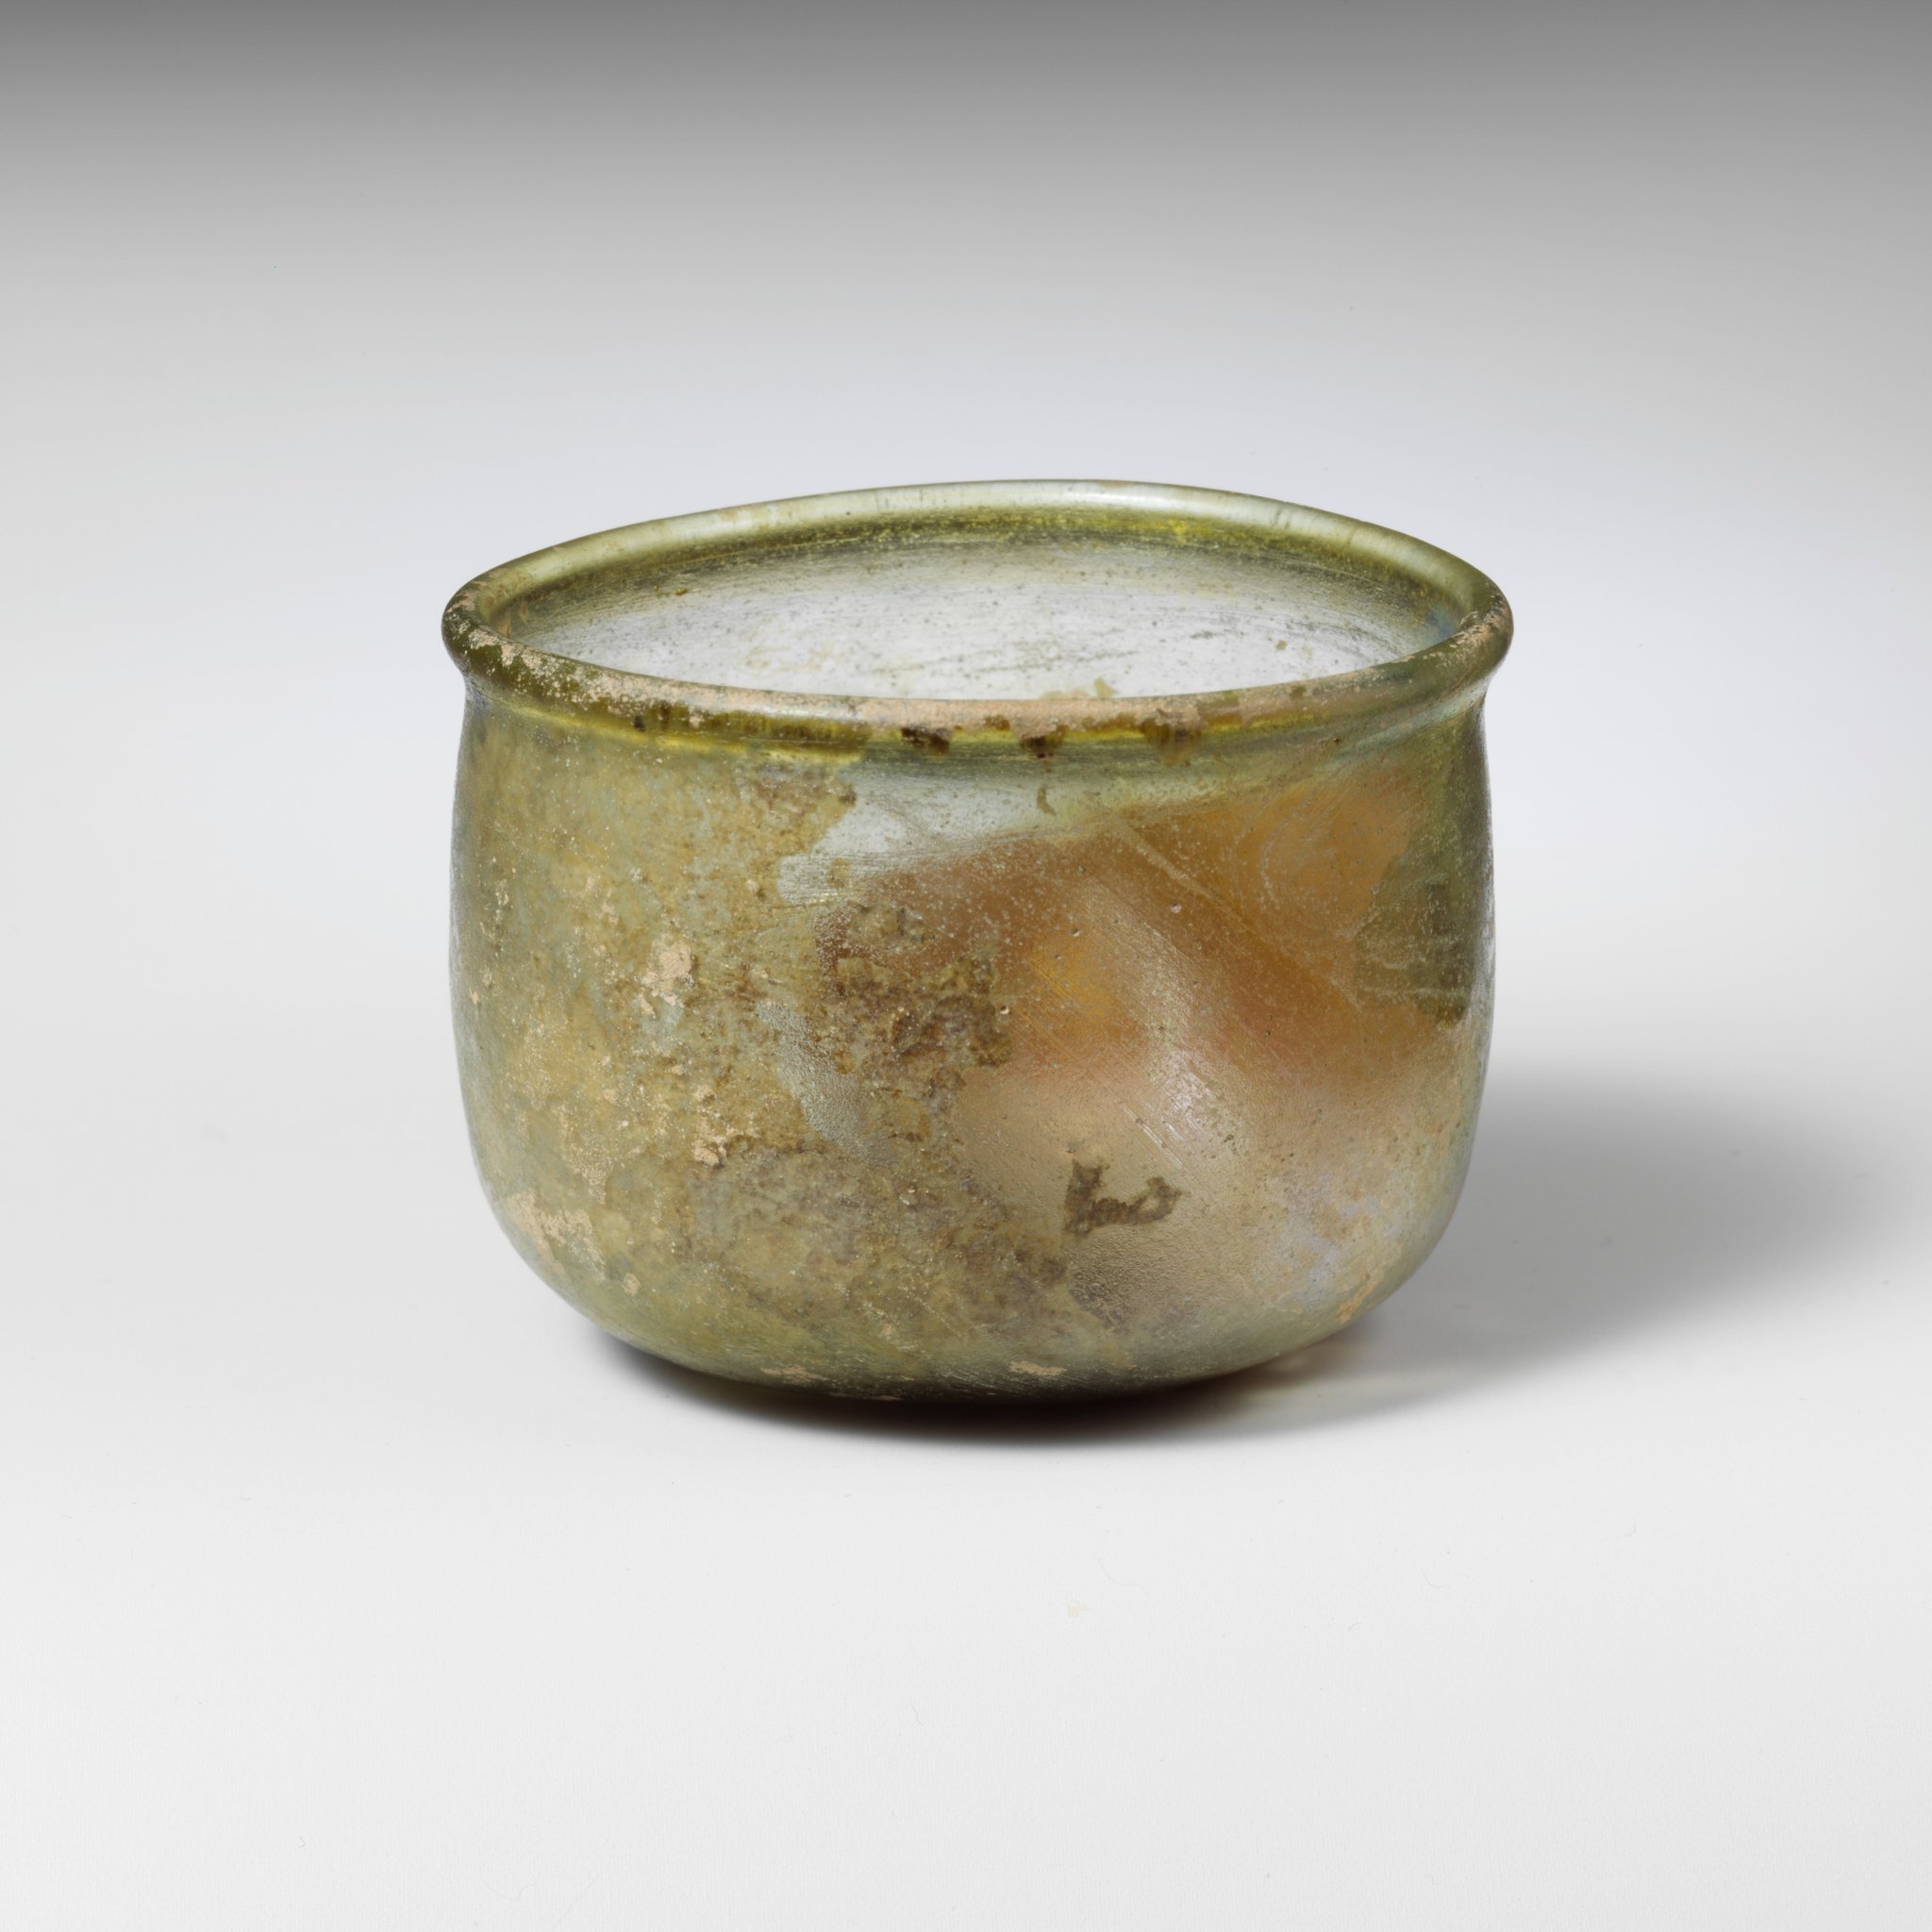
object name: bowl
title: Glass cup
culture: roman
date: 101-300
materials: glass